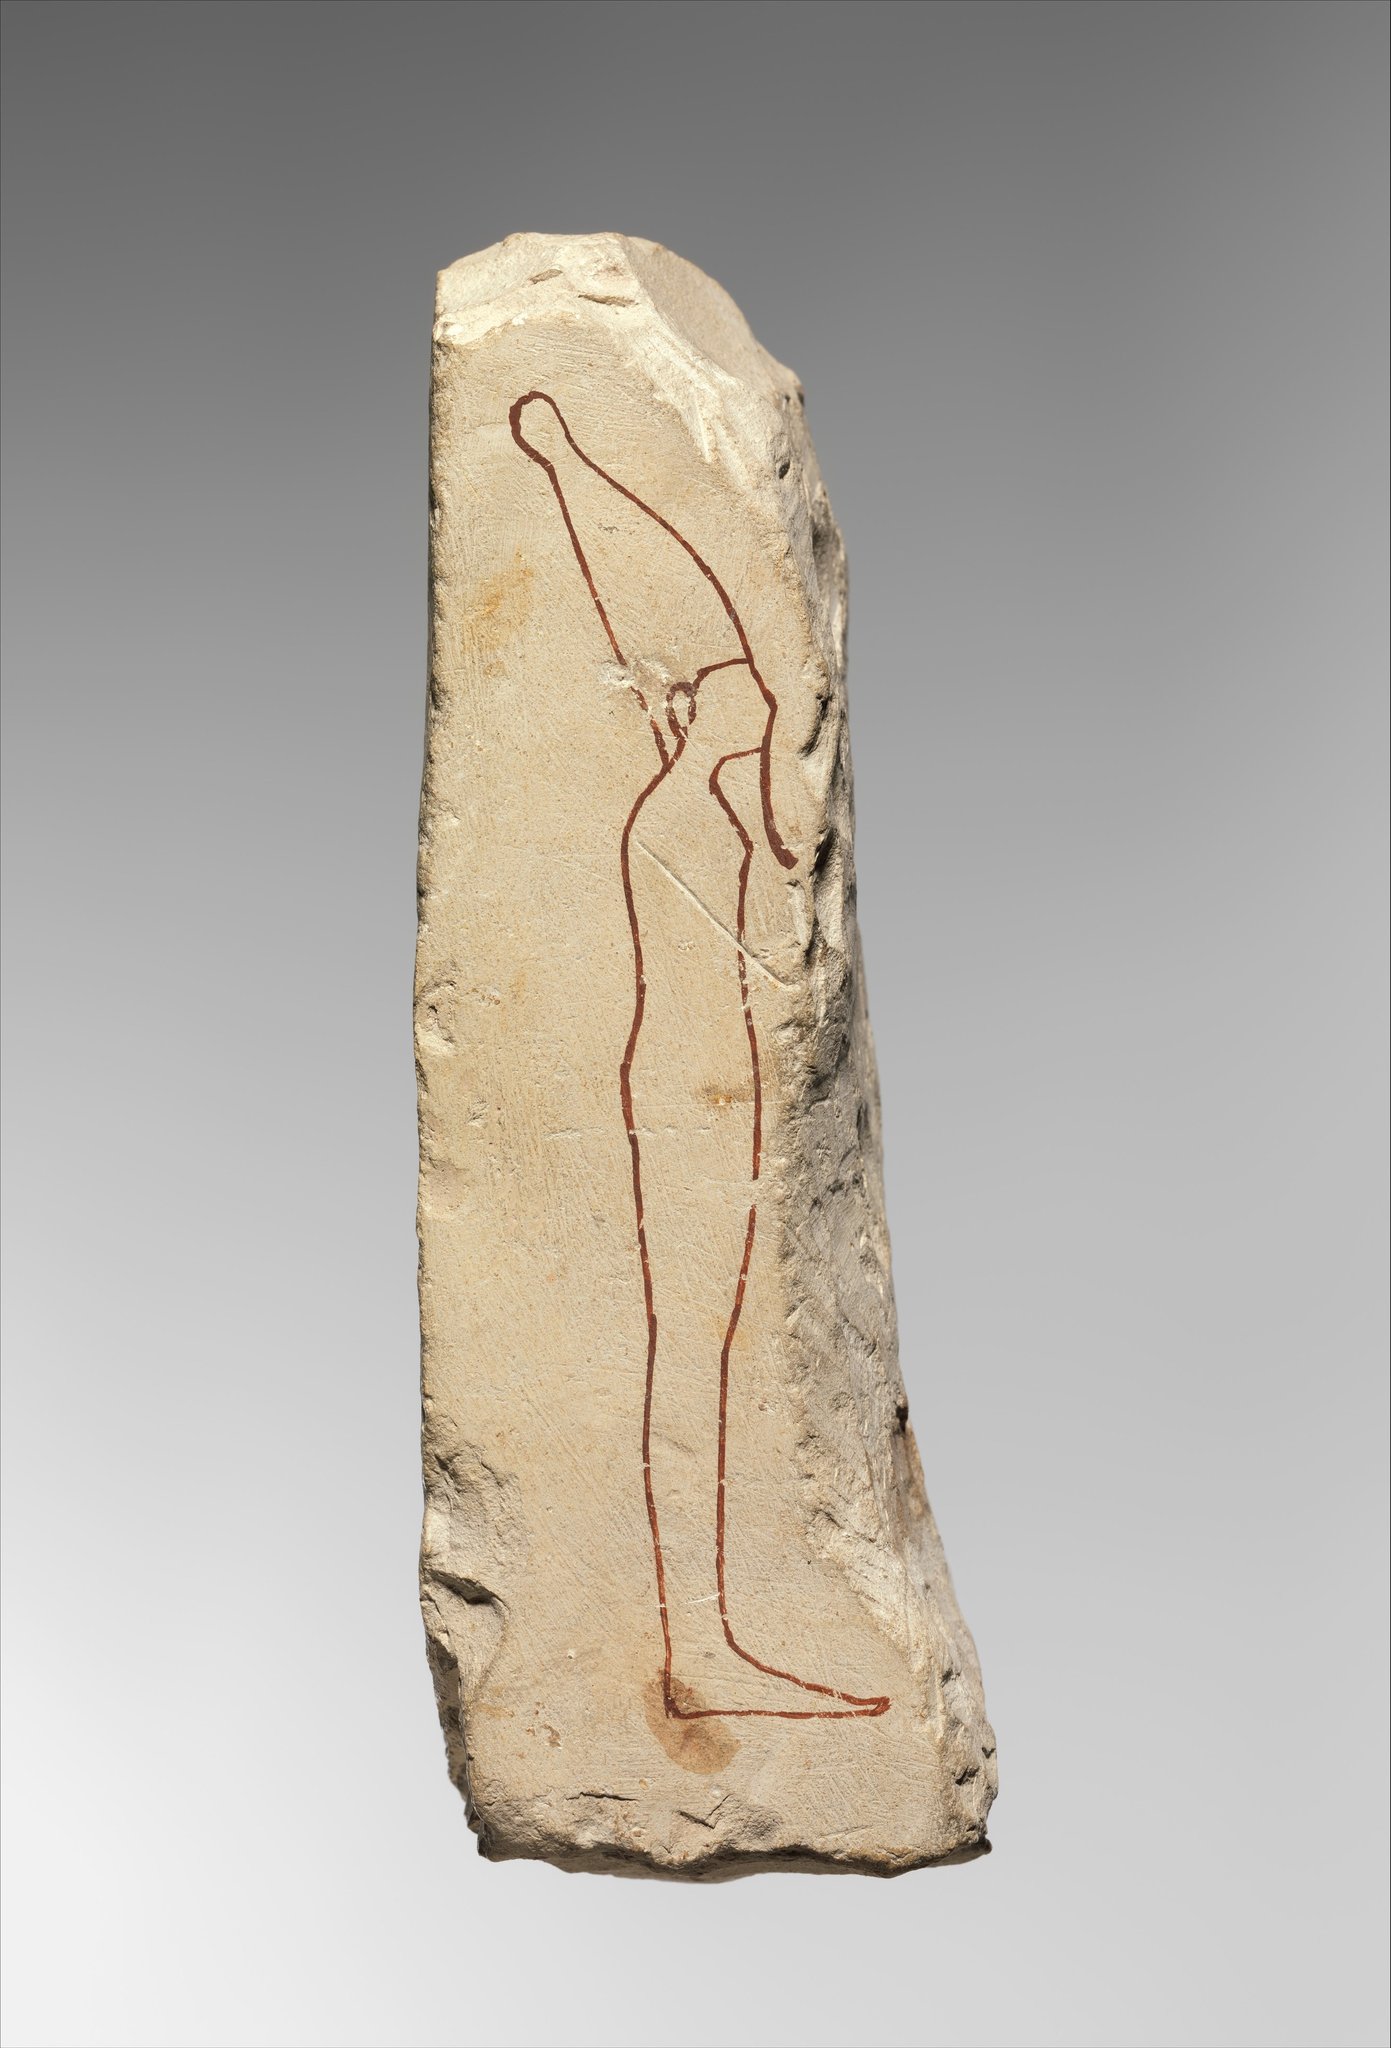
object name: unifinished workshop piece with drawing of osiris or khentamentiu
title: Unfinished Statuette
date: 1980-1975 BCE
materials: ink, limestone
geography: egypt